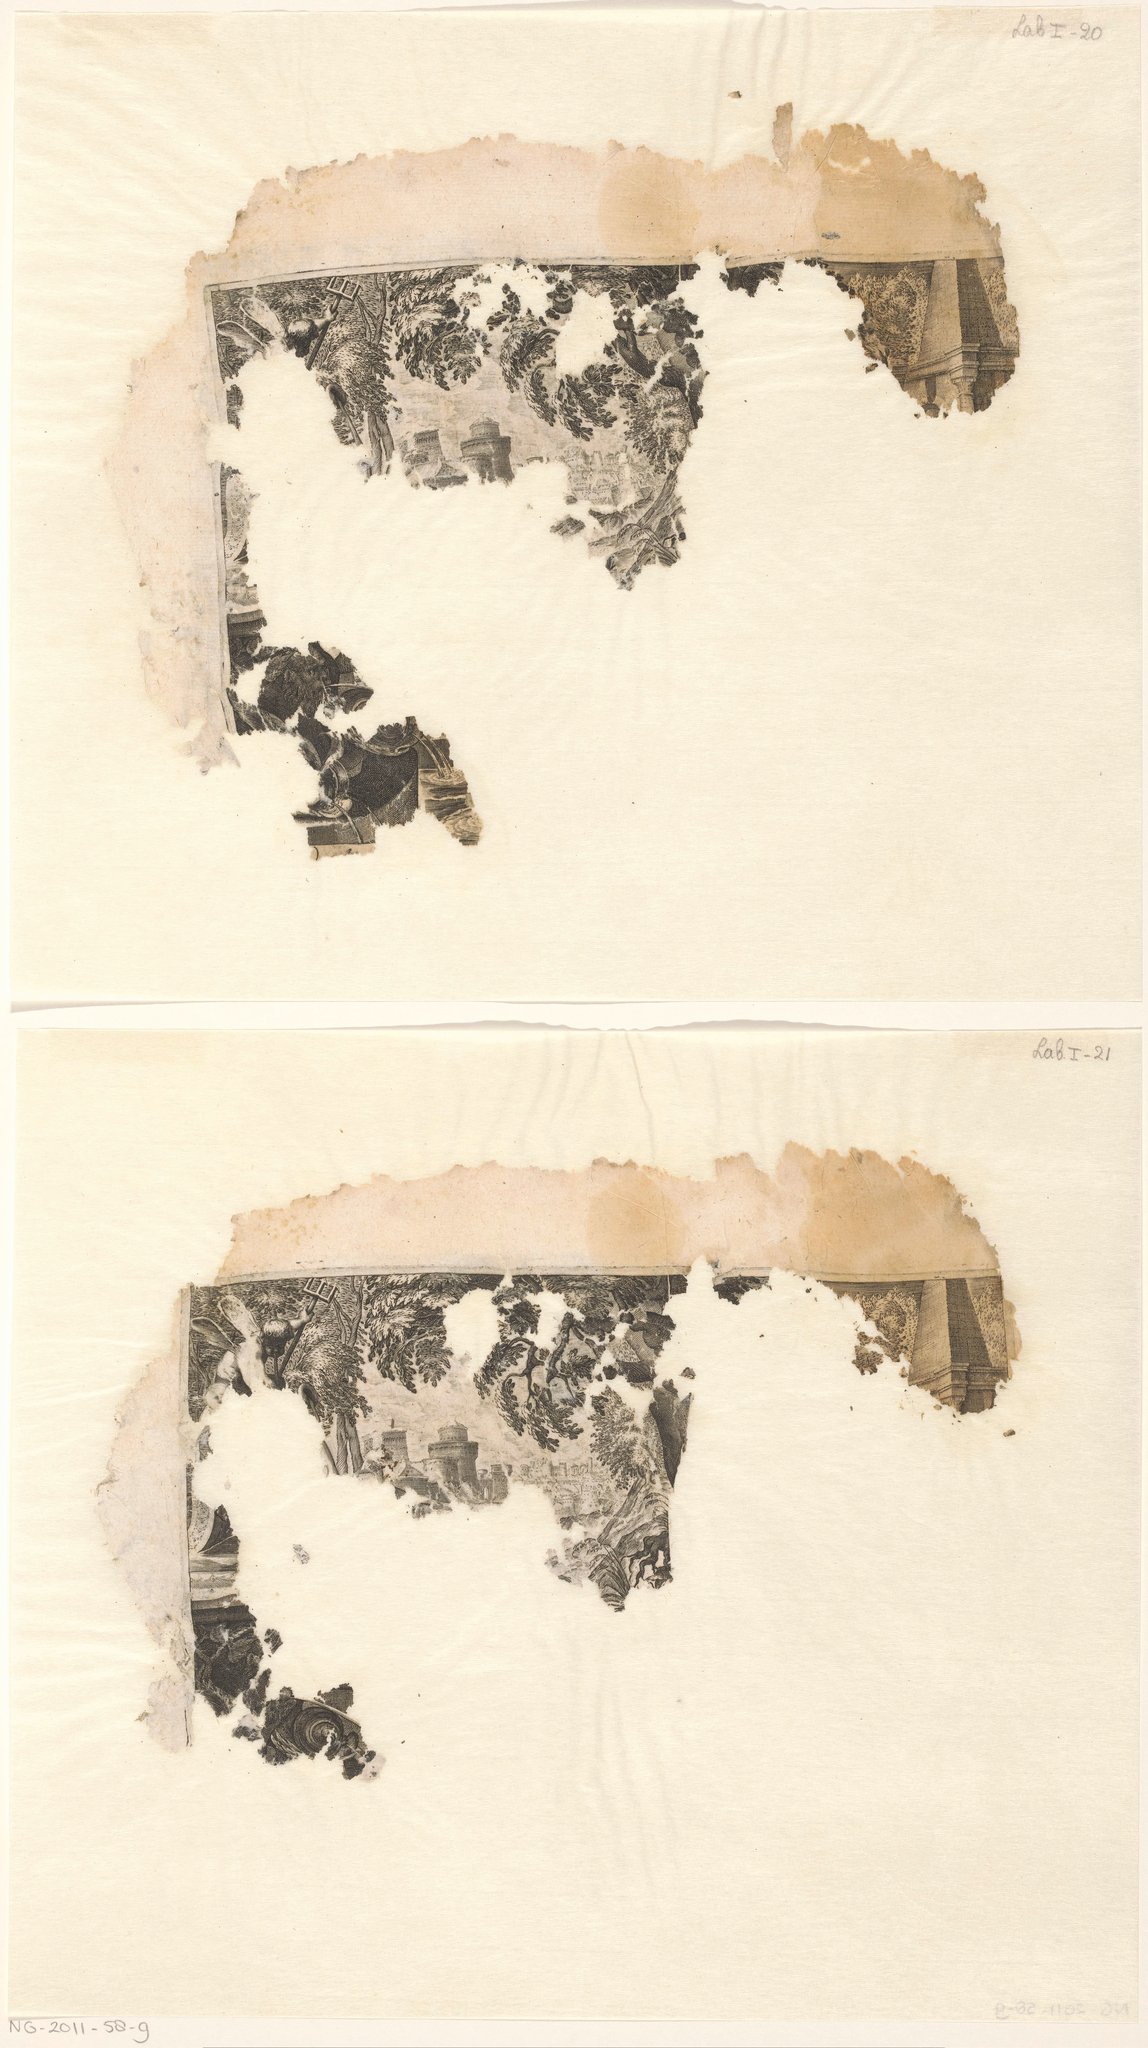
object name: print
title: Fragmenten van prenten van Pyramus en Thisbe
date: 1580-1596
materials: paper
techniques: engraving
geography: northern netherlands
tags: thisbe kills herself with pyramus' sword (the scene may be represented near a fountain)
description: De prenten in de Nova Zembla collectie zijn tijdens een expeditie van Willem Barendsz en Jacob van Heemskerk in 1596-1597 noodgedwongen in het winterkamp, het ‘Behouden Huis’, op het eiland achtergelaten. De prenten waren in één of meerdere stapels als handelswaar meegenomen vanuit Amsterdam. Bijna drie eeuwen later, in 1871, keerde de Noor Elling Carlsen terug naar Nova Zembla en vond daar de restanten van het ‘Behouden Huis, inclusief een groot deel van de inventaris. Een deel van de prenten, in de vorm van aaneengekoekte kluiten, werd toen ook teruggevonden. De papierkluiten waren soms op meerdere plekken gebroken. Tussen 1975-1979 zijn de prenten van elkaar gescheiden. Dit leverde in totaal ca. 1000 fragmenten van ca. 400 afdrukken van ca. 150 verschillende prenten op. Voor zover mogelijk zijn de fragmenten samengevoegd en zijn de prenten gereconstrueerd.